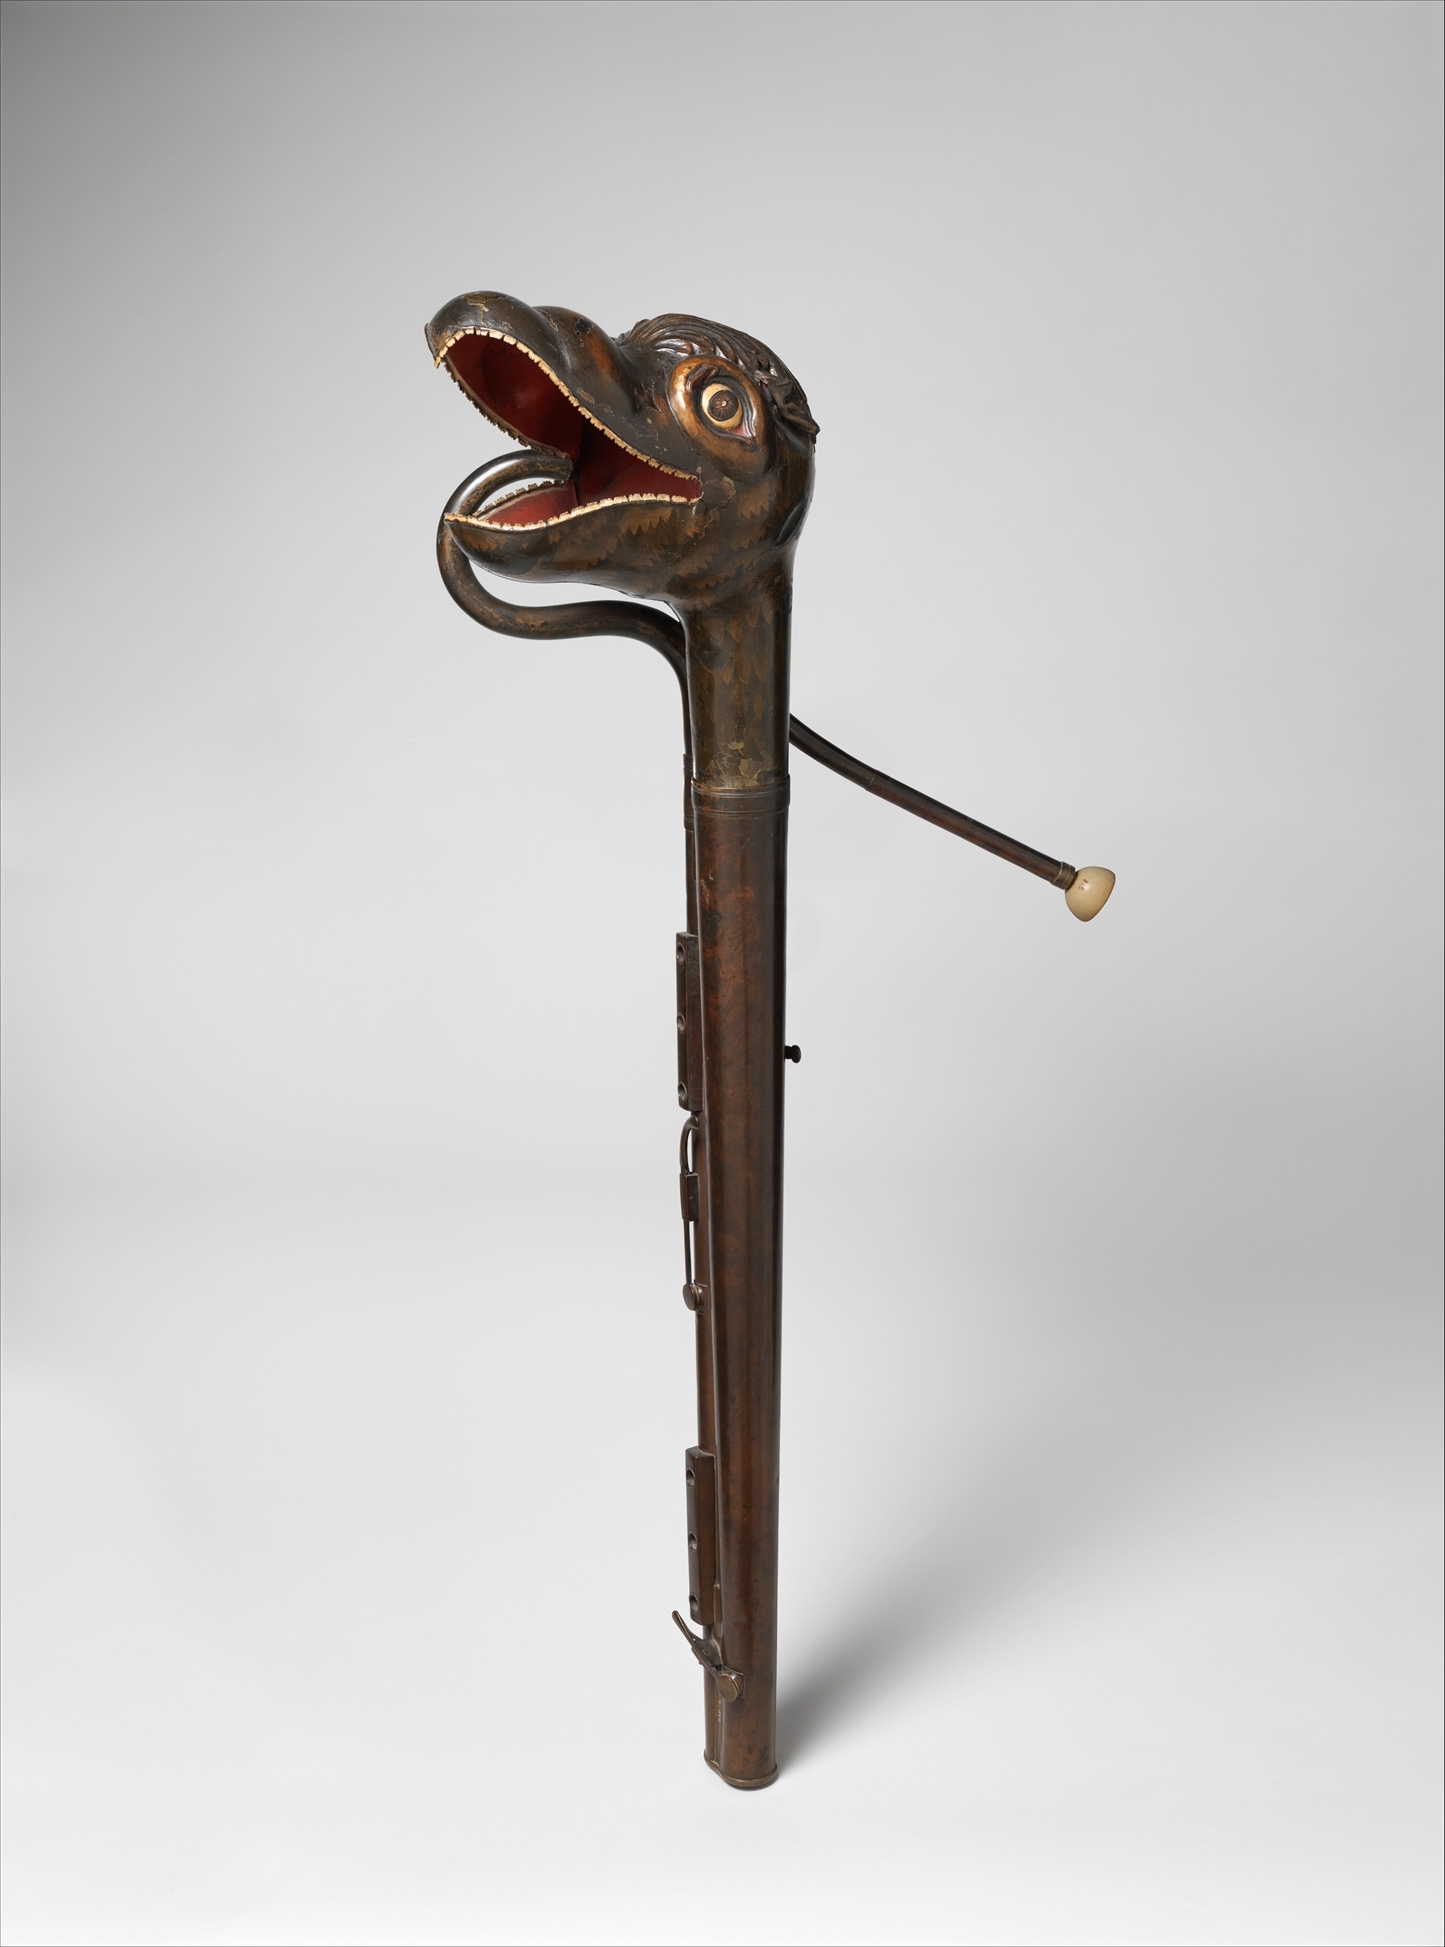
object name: upright serpent in d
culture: italian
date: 1810-1820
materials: brass, paint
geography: italy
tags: dragons